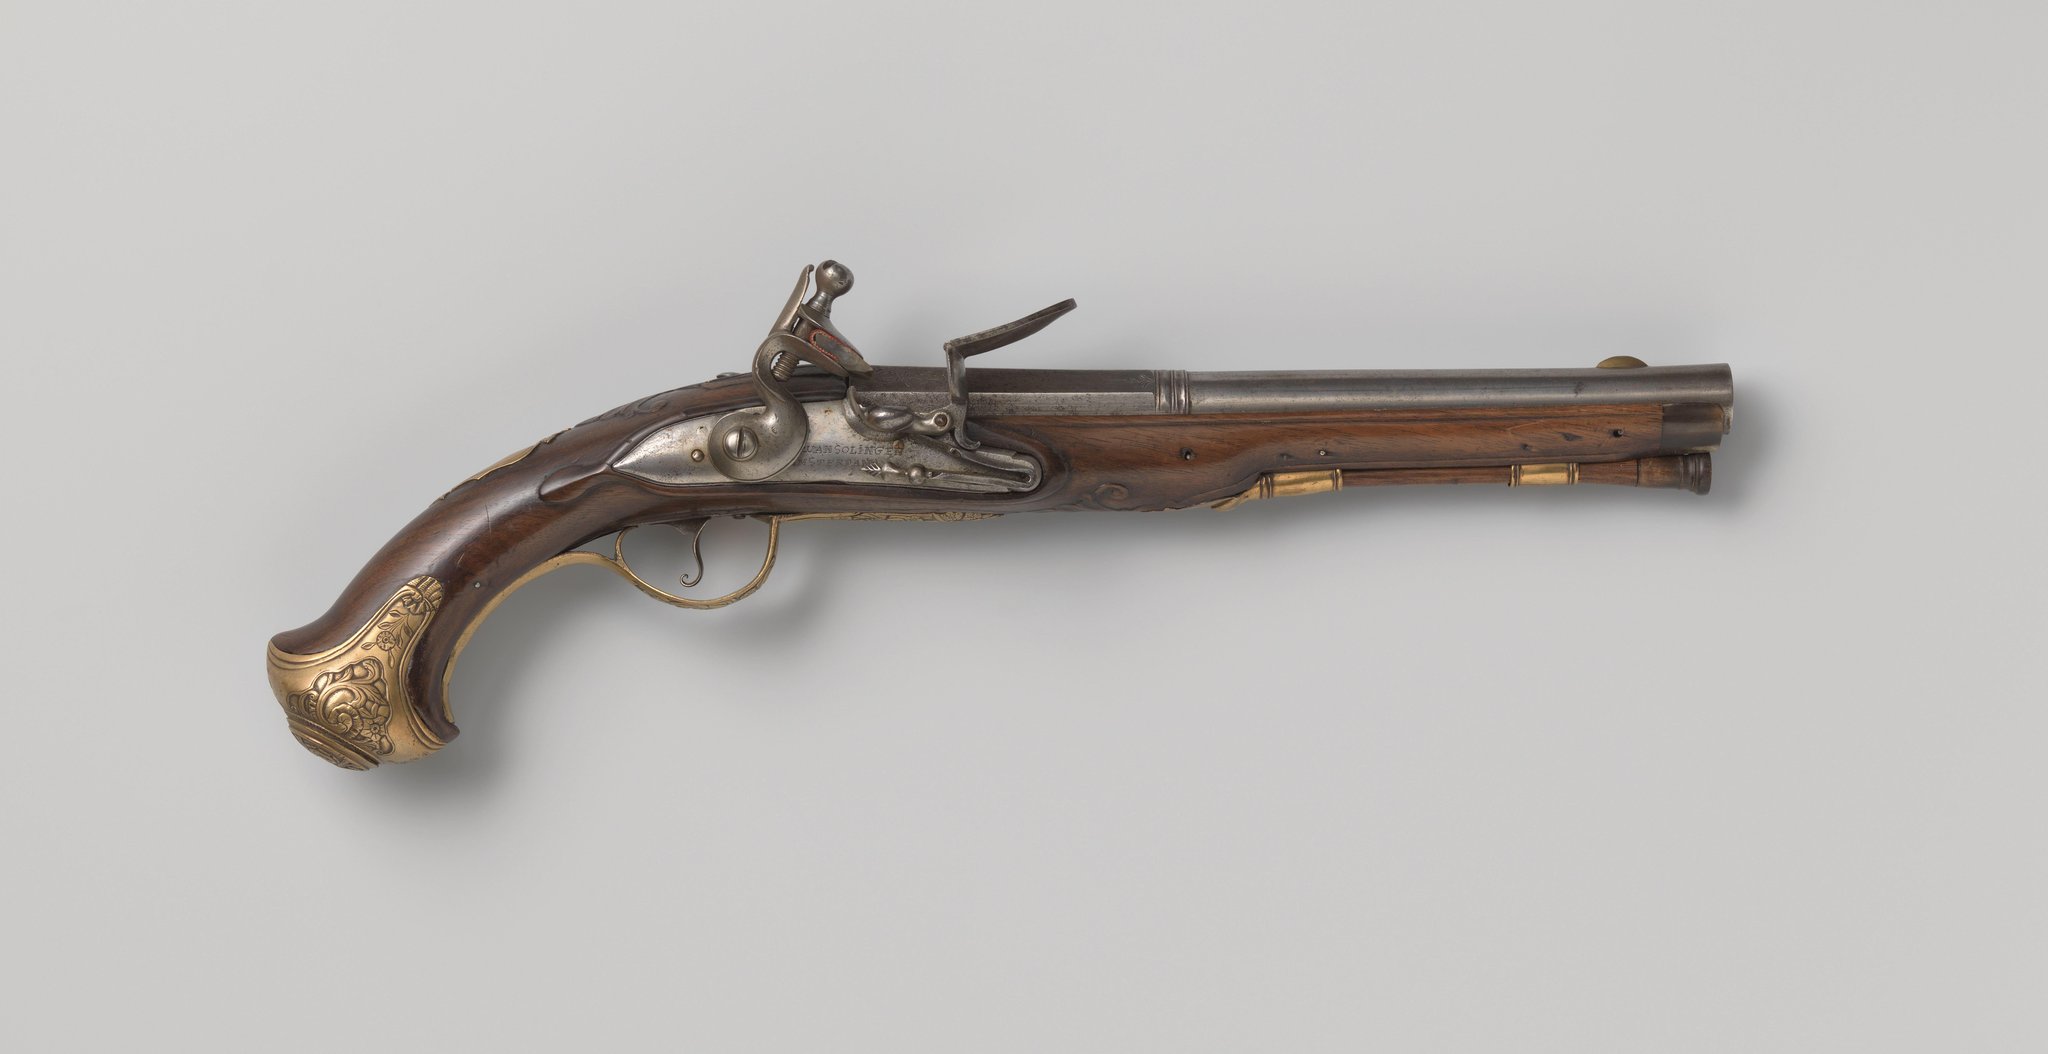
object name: flintlock pistol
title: Vuursteenpistool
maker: jacobus van solingen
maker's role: geweermaker, pistoolmaker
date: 1770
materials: brass, stone, horn, iron, wood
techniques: printing, metalworking, cutting, embroidery, engraving, gilding, relief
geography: amsterdam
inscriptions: coat of arms, inscription: ‘I:VAN SOLINGEN // AMSTERDAM’, : ‘J : P’